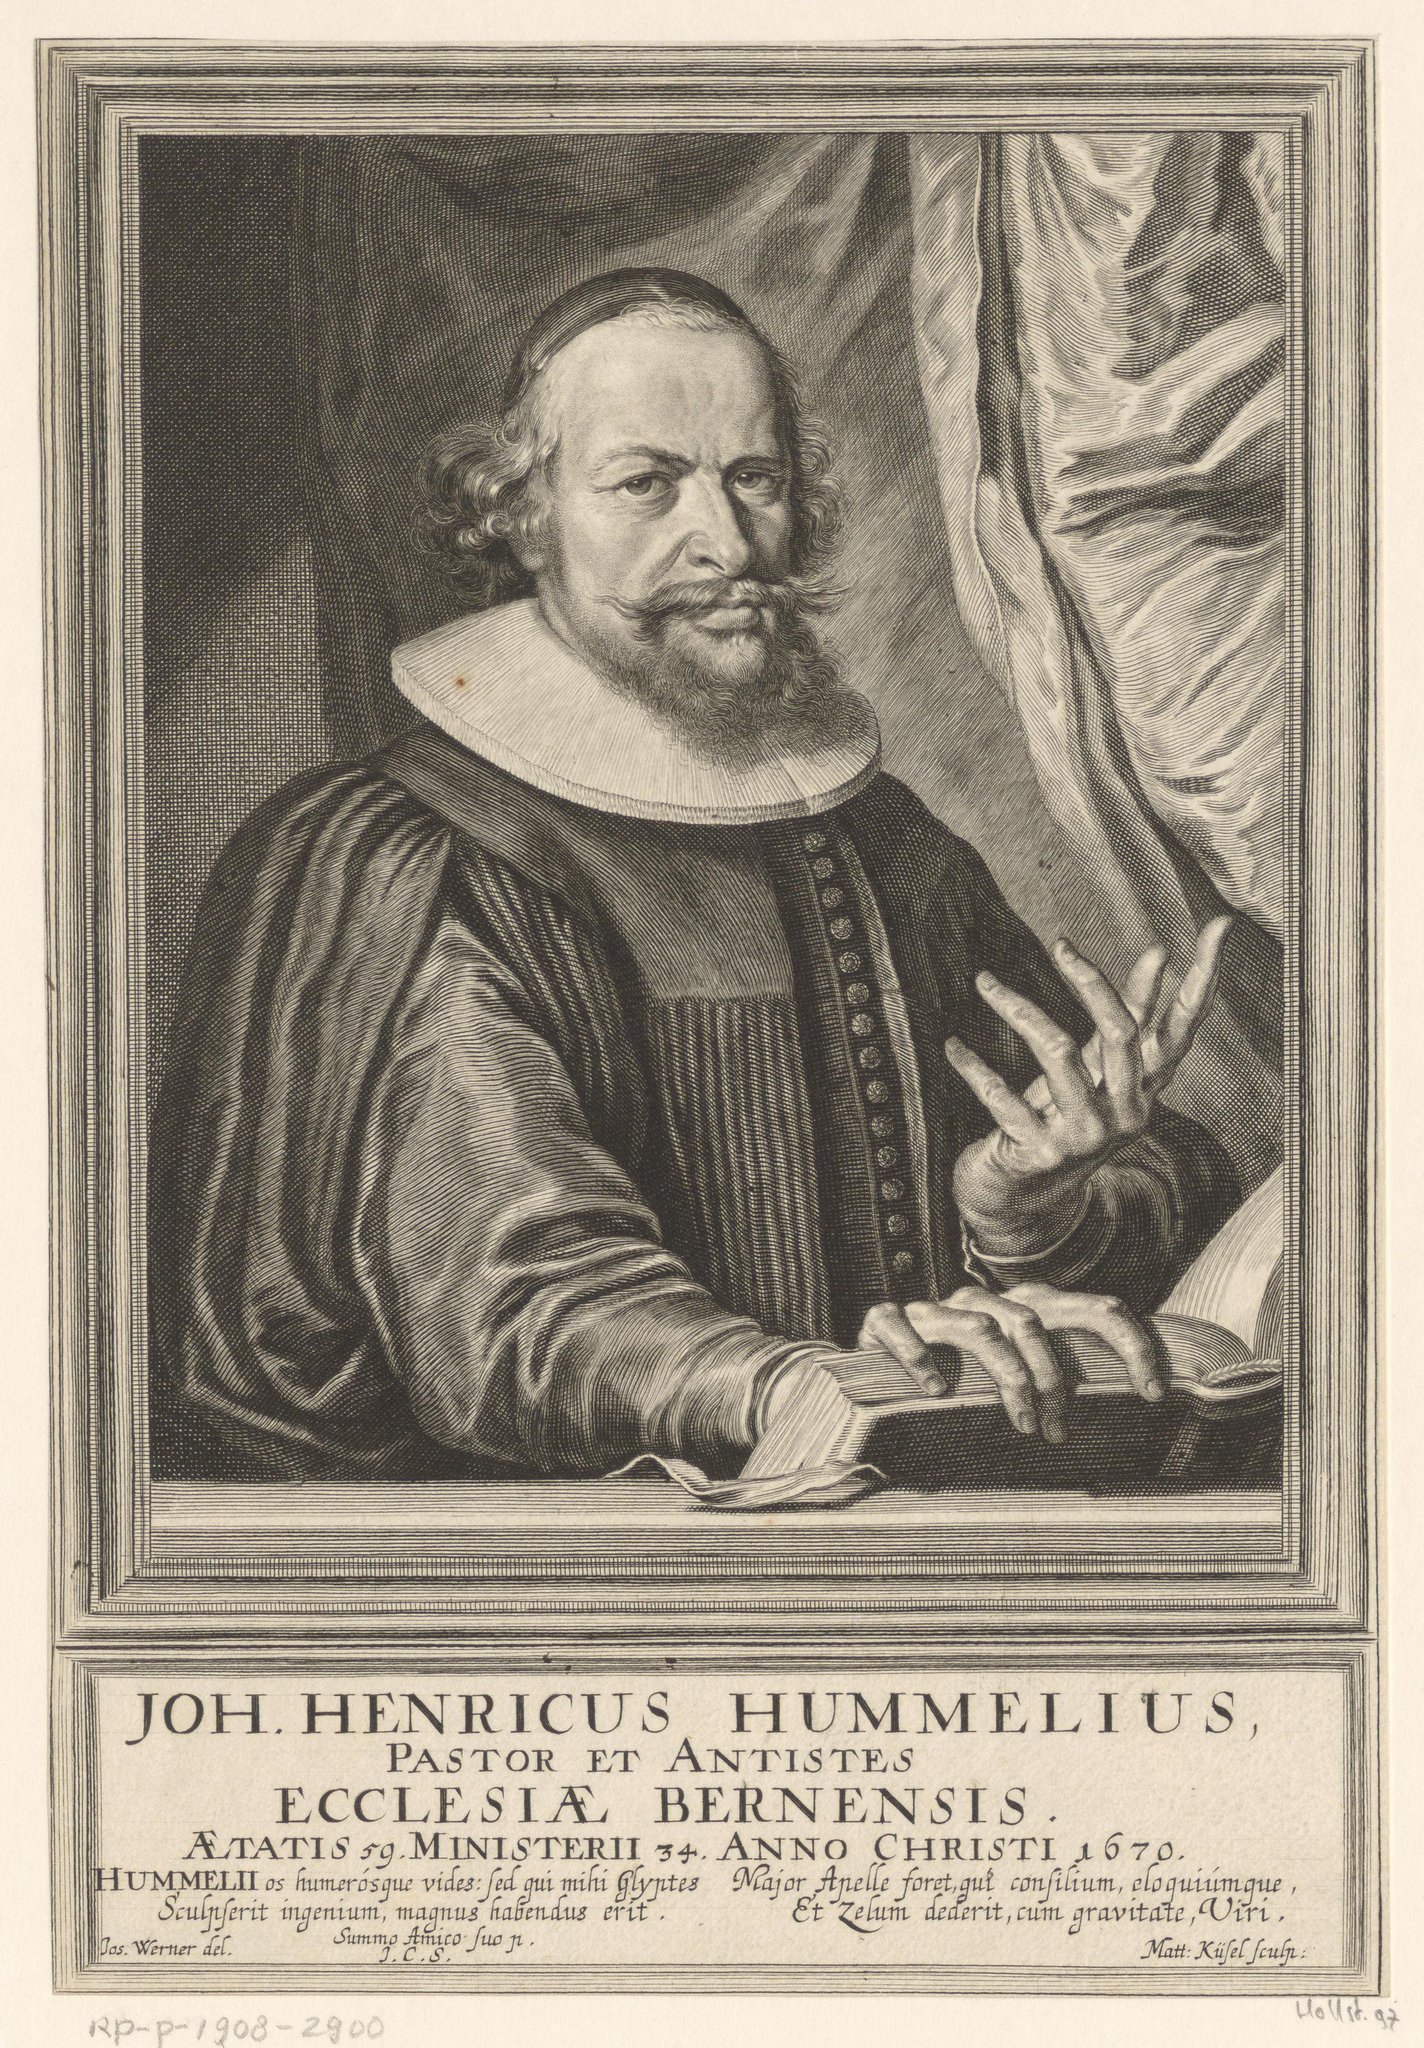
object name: print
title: Portret van Johann Heinrich Hummel op 59-jarige leeftijd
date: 1670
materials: paper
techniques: engraving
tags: theologian, further education (+ portrait of teacher, professor), historical persons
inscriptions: collector's mark: Lugt 2228